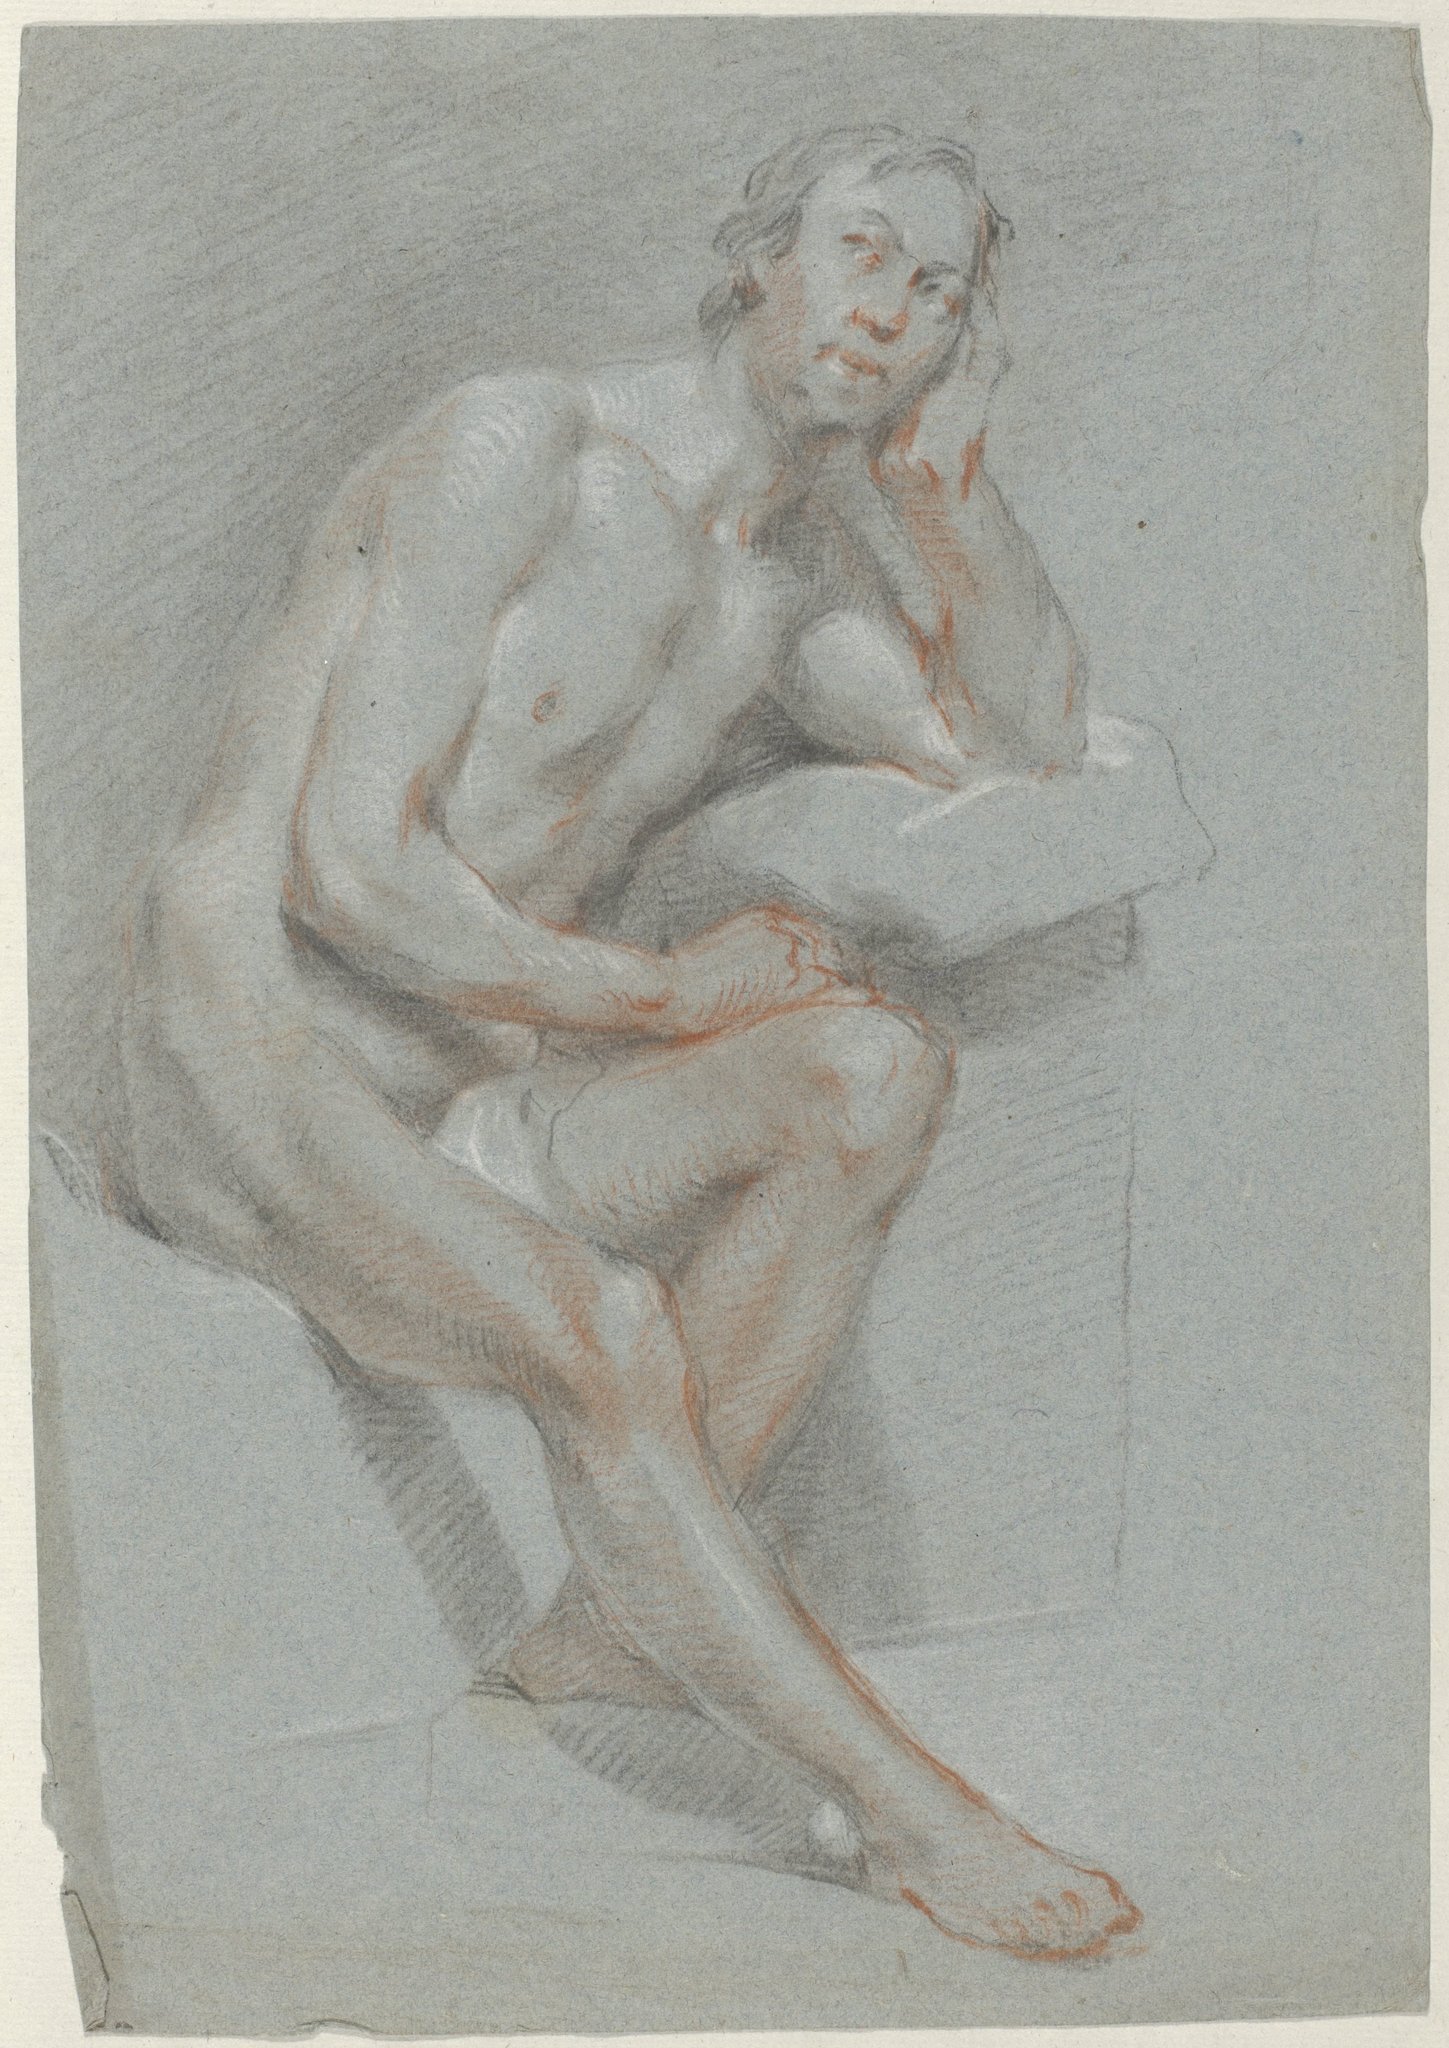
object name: drawing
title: Zittende naakte man, zijn hoofd met zijn hand ondersteunend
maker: hendrik willem schweickhardt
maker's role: draughtsman, painter, print maker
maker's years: 1746-1797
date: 1756-1797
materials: chalk, paper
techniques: brush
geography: netherlands